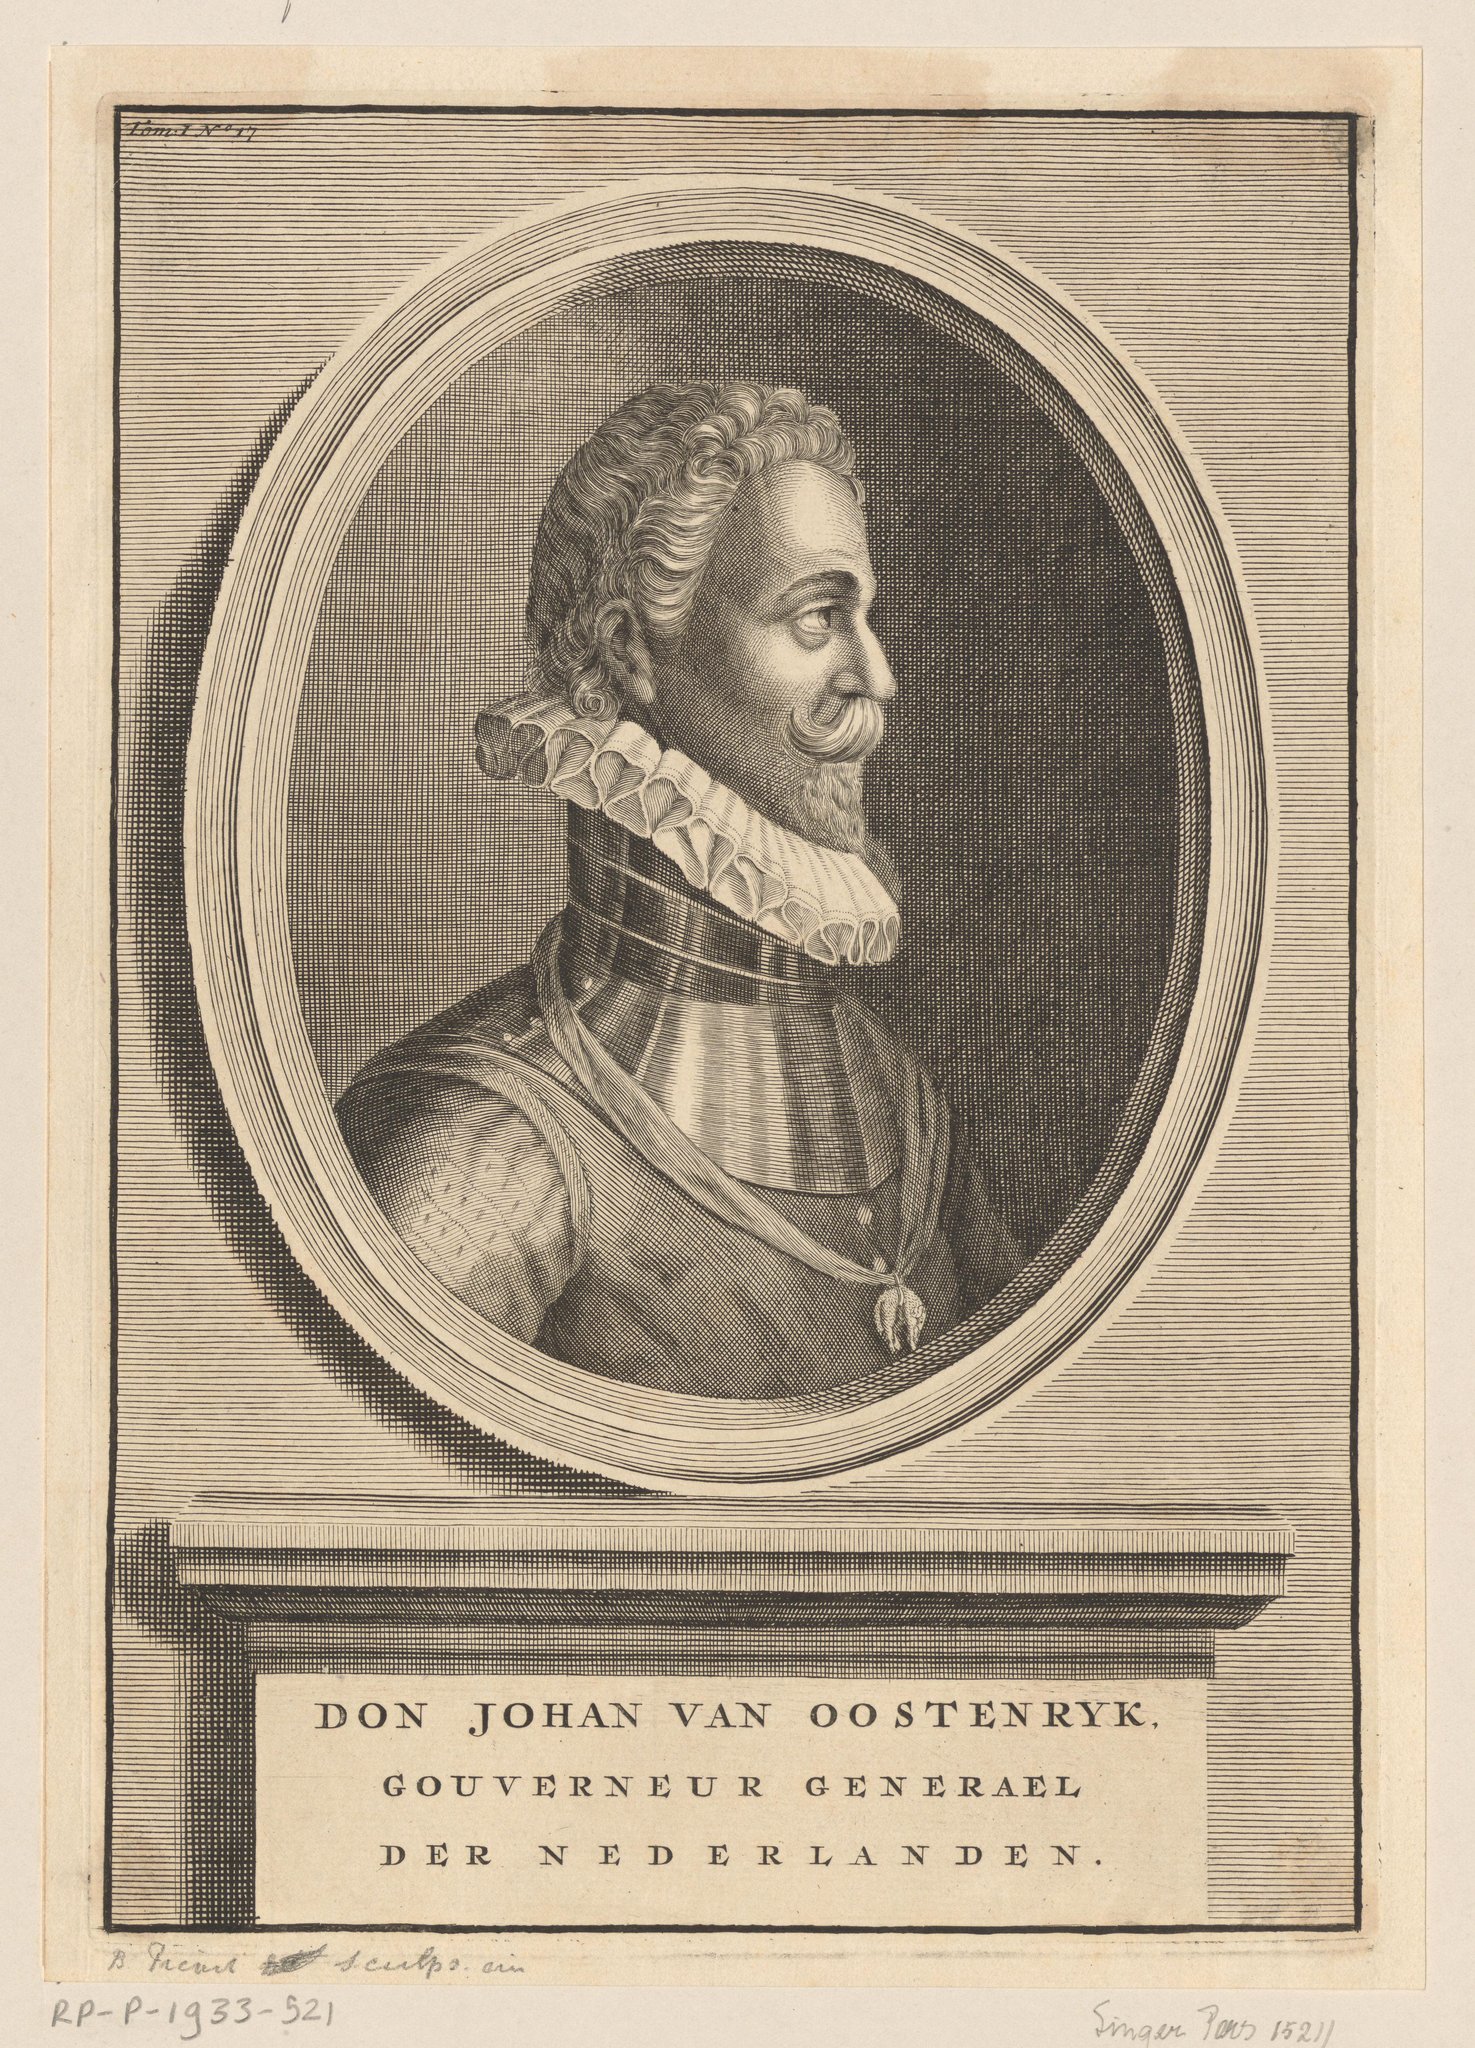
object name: print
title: Portret van Don Juan van Oostenrijk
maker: Anonymous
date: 1730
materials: paper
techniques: engraving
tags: don juan van oostenrijk, historical persons, knighthood order of the golden fleece, ruler, sovereign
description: Prent mogelijk uit: Le Clerc, Jean. Geschiedenissen der Vereenigde Nederlanden (...). Amsterdam: Zacharias Chatelain, 1730. Eerdere staat van prent gebruikt in: Bor, Pieter Christiaensz. Oorsprongk, begin en vervolgh der Nederlandsche oorlogen (...). Amsterdam: weduwe Joannes van Someren et al., 1679. En in: Hooft, Pieter Corneliszoon. Nederlandsche historien, seedert de ooverdraght der heerschappye van kaizar Karel den Vyfden op koning Philips zynen zoon, tot het einde der landtvooghdye des graven van Leicester. Amsterdam: Hendrik Wetstein en Pieter Sceperus en Leiden: Daniel van den Dalen en Utrecht: Willem van de Water, 1703, dl. 1.